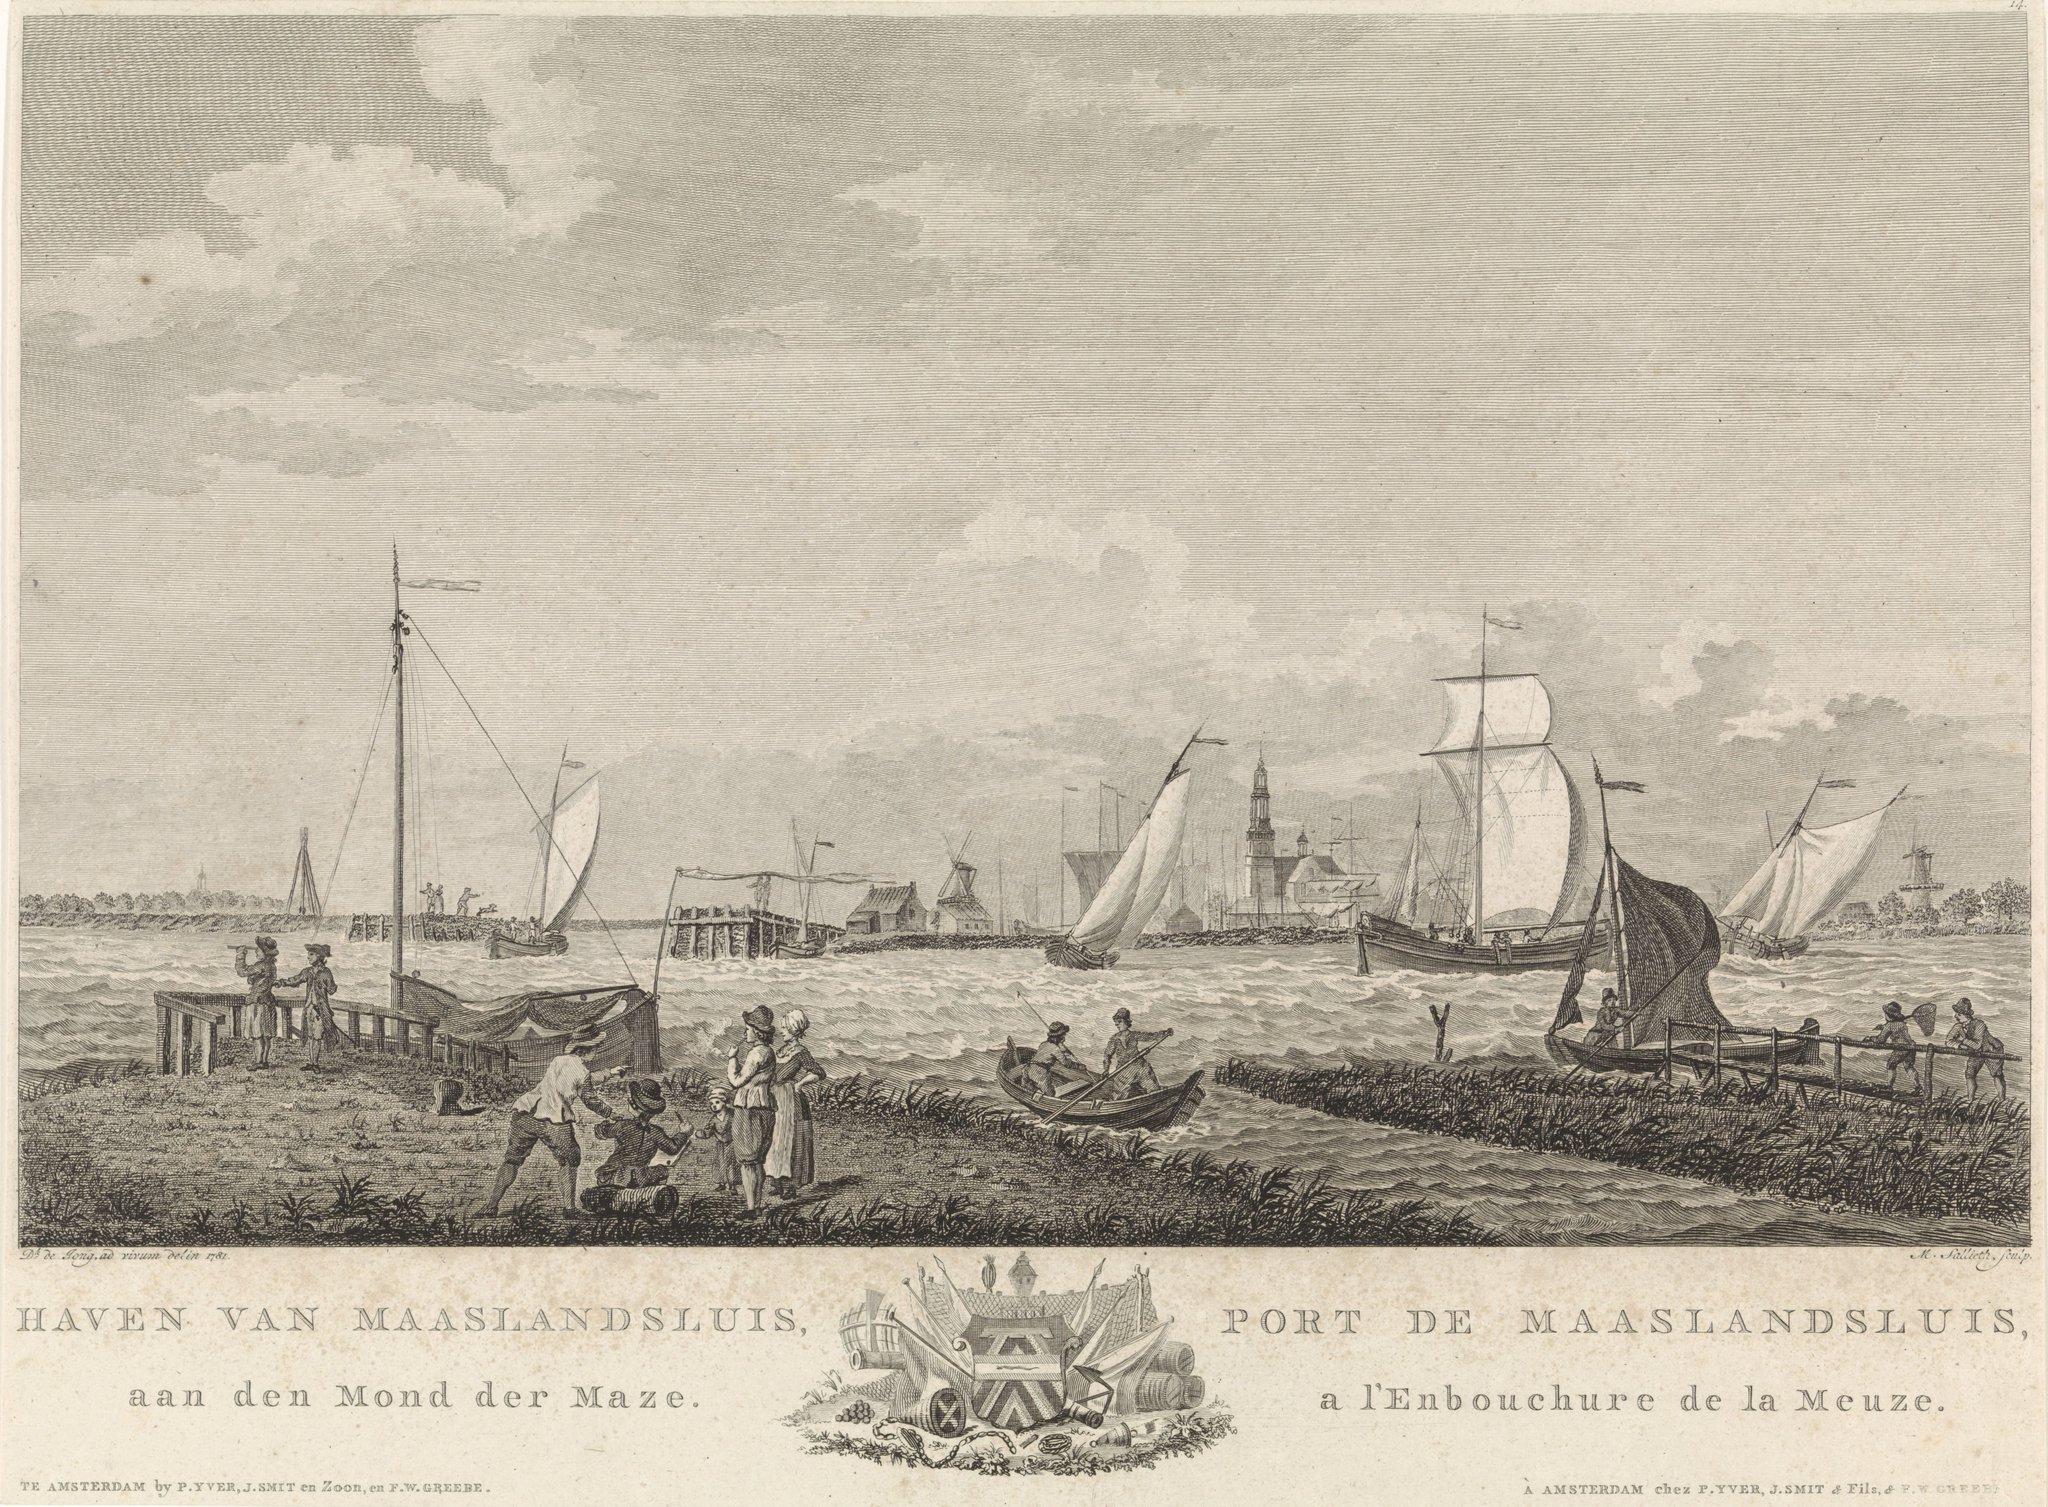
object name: print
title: Gezicht op de haven van Maassluis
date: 1781-1787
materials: paper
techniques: engraving, etching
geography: amsterdam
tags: harbour, coat of arms (as symbol of the state, etc.) (+ city; municipal), sailing-ship, sailing-boat, church (exterior), prospect of city, town panorama, silhouette of city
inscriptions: collector's mark: Lugt 2228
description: Latere staat ook gebruikt in: Aa, Cornelis van der. Atlas van de zeehavens der Bataafsche Republiek. Met derzelver beschrijvingen in XXXI kunstplaaten / Atlas van de zeehavens der Bataafsche Republiek, die van Batavia en Onrust. Mitsgaders de afbeeldingen van de haringvisscherij en de walvischvangst (…). Amsterdam: Evert Maaskamp, 1805.